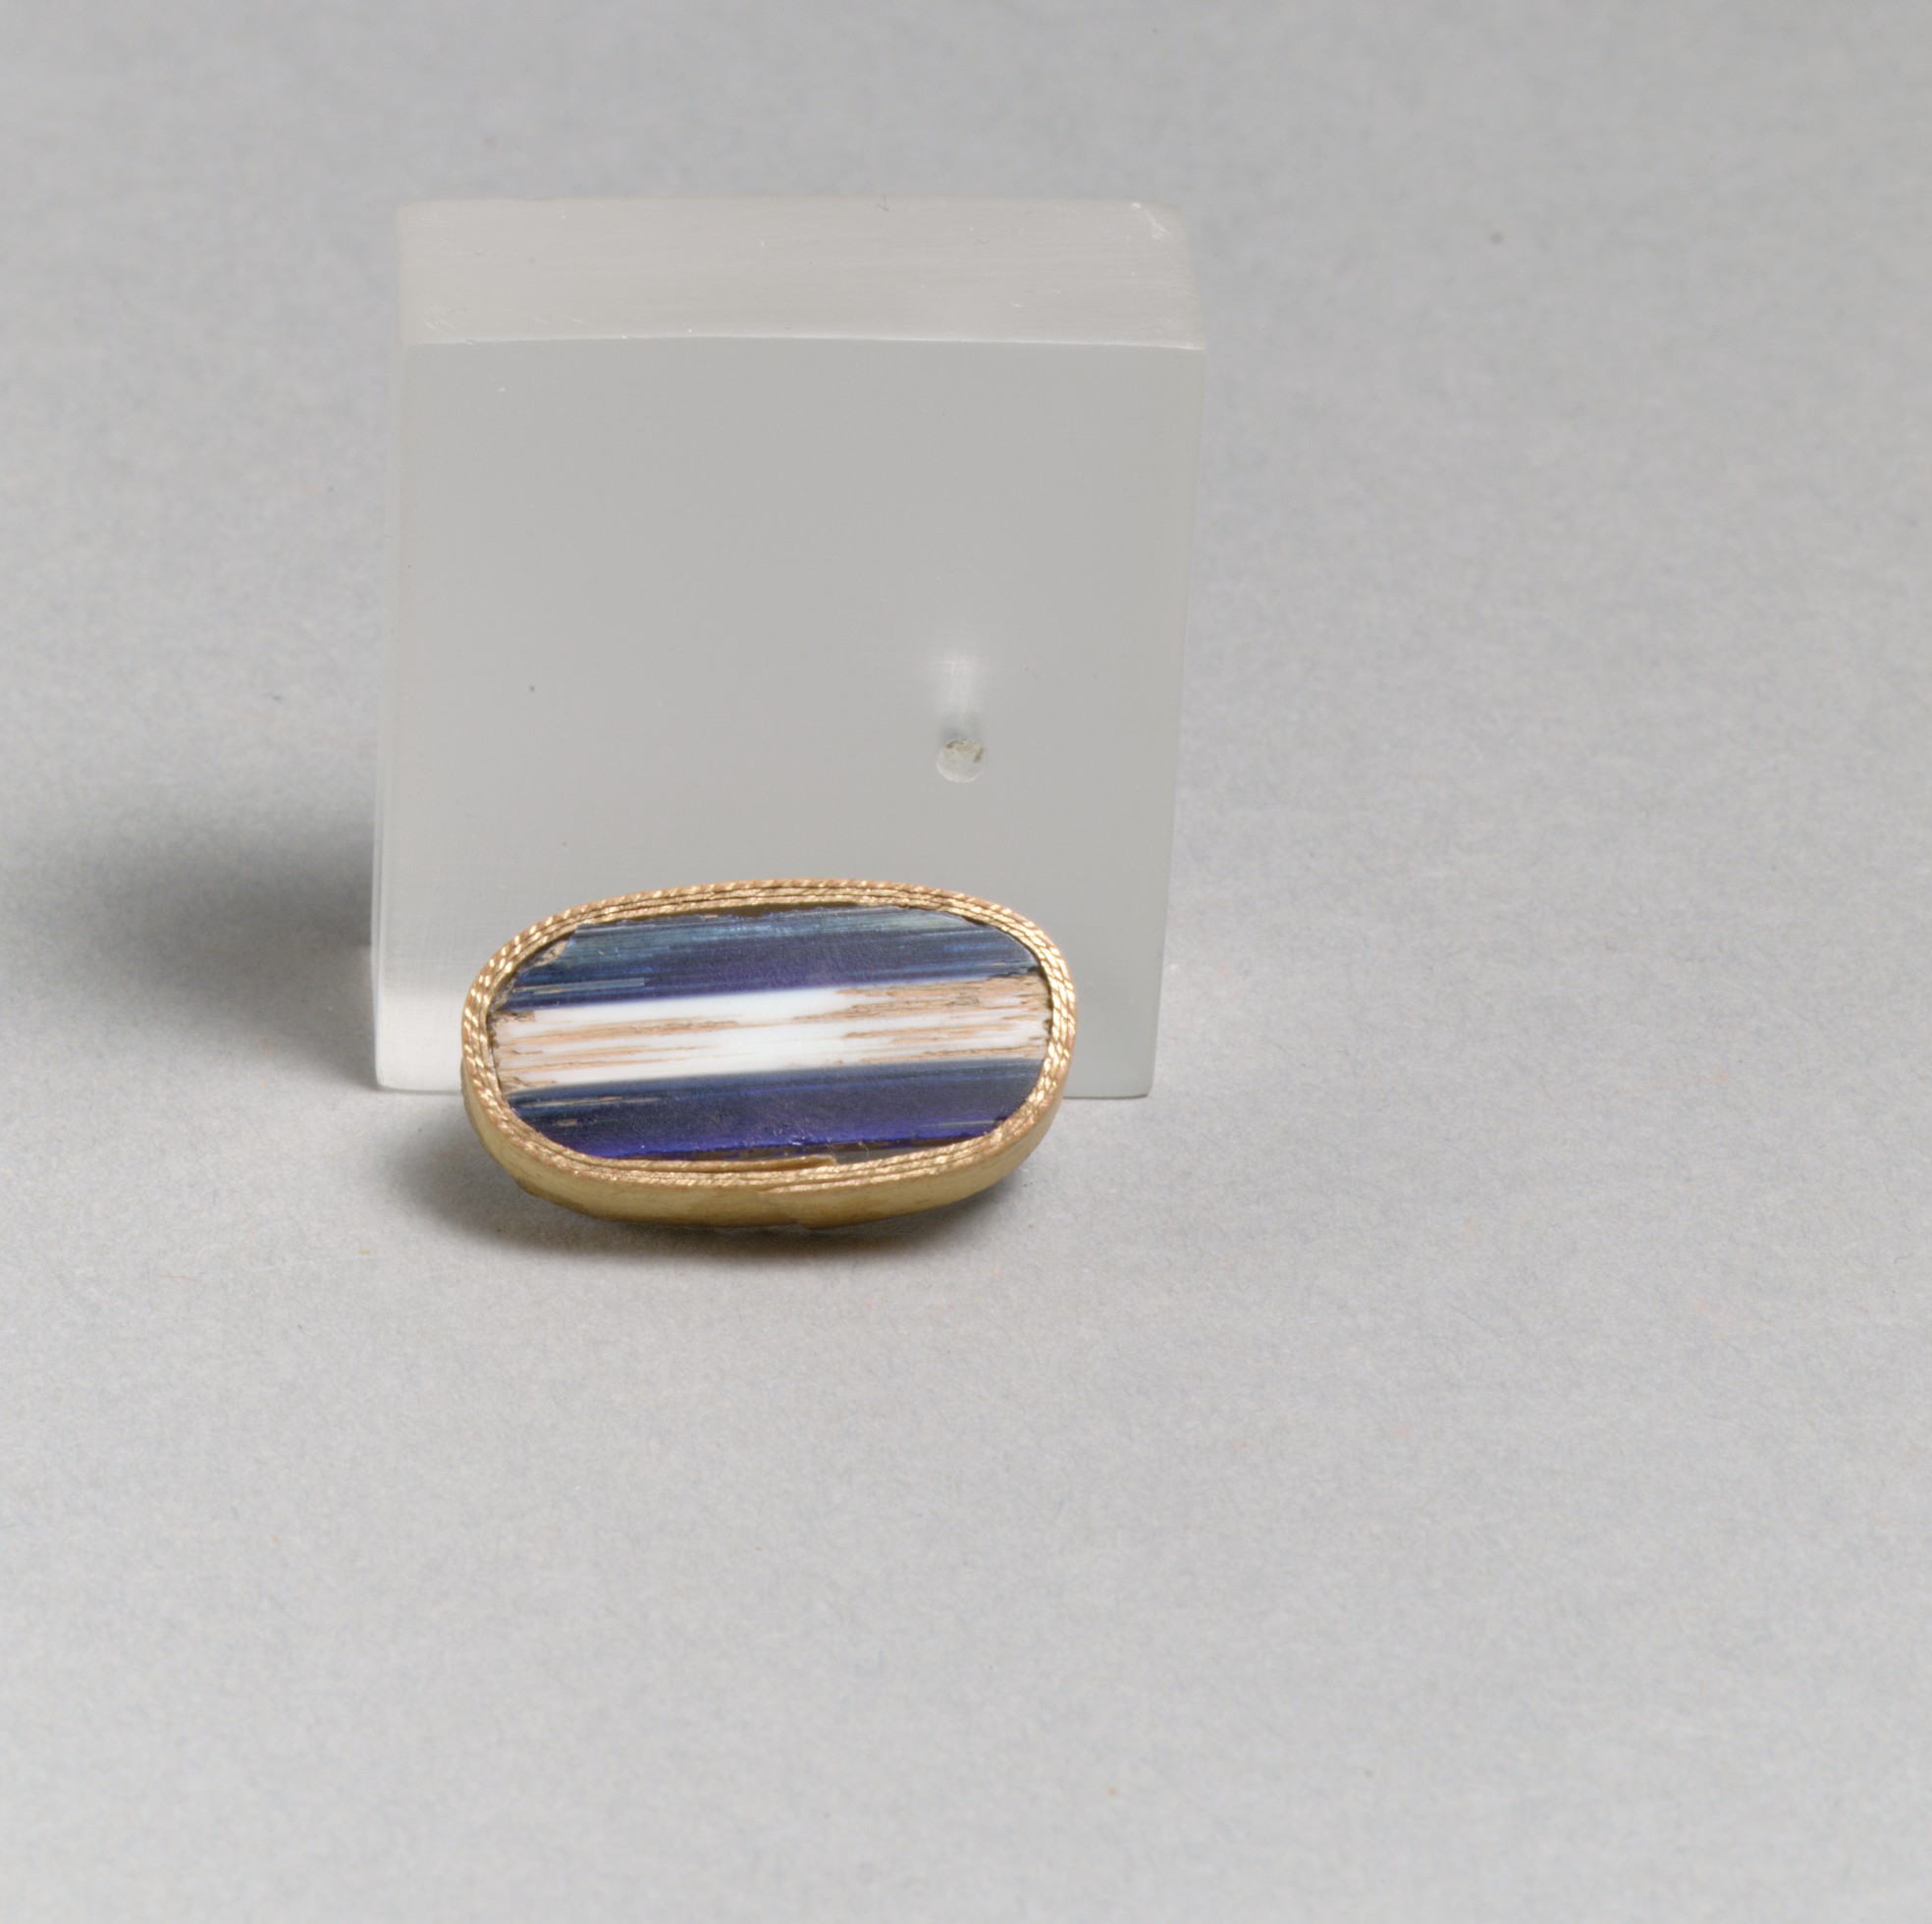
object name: fragment, inlay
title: Glass inlay fragment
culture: roman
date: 34 BCE-33 CE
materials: glass